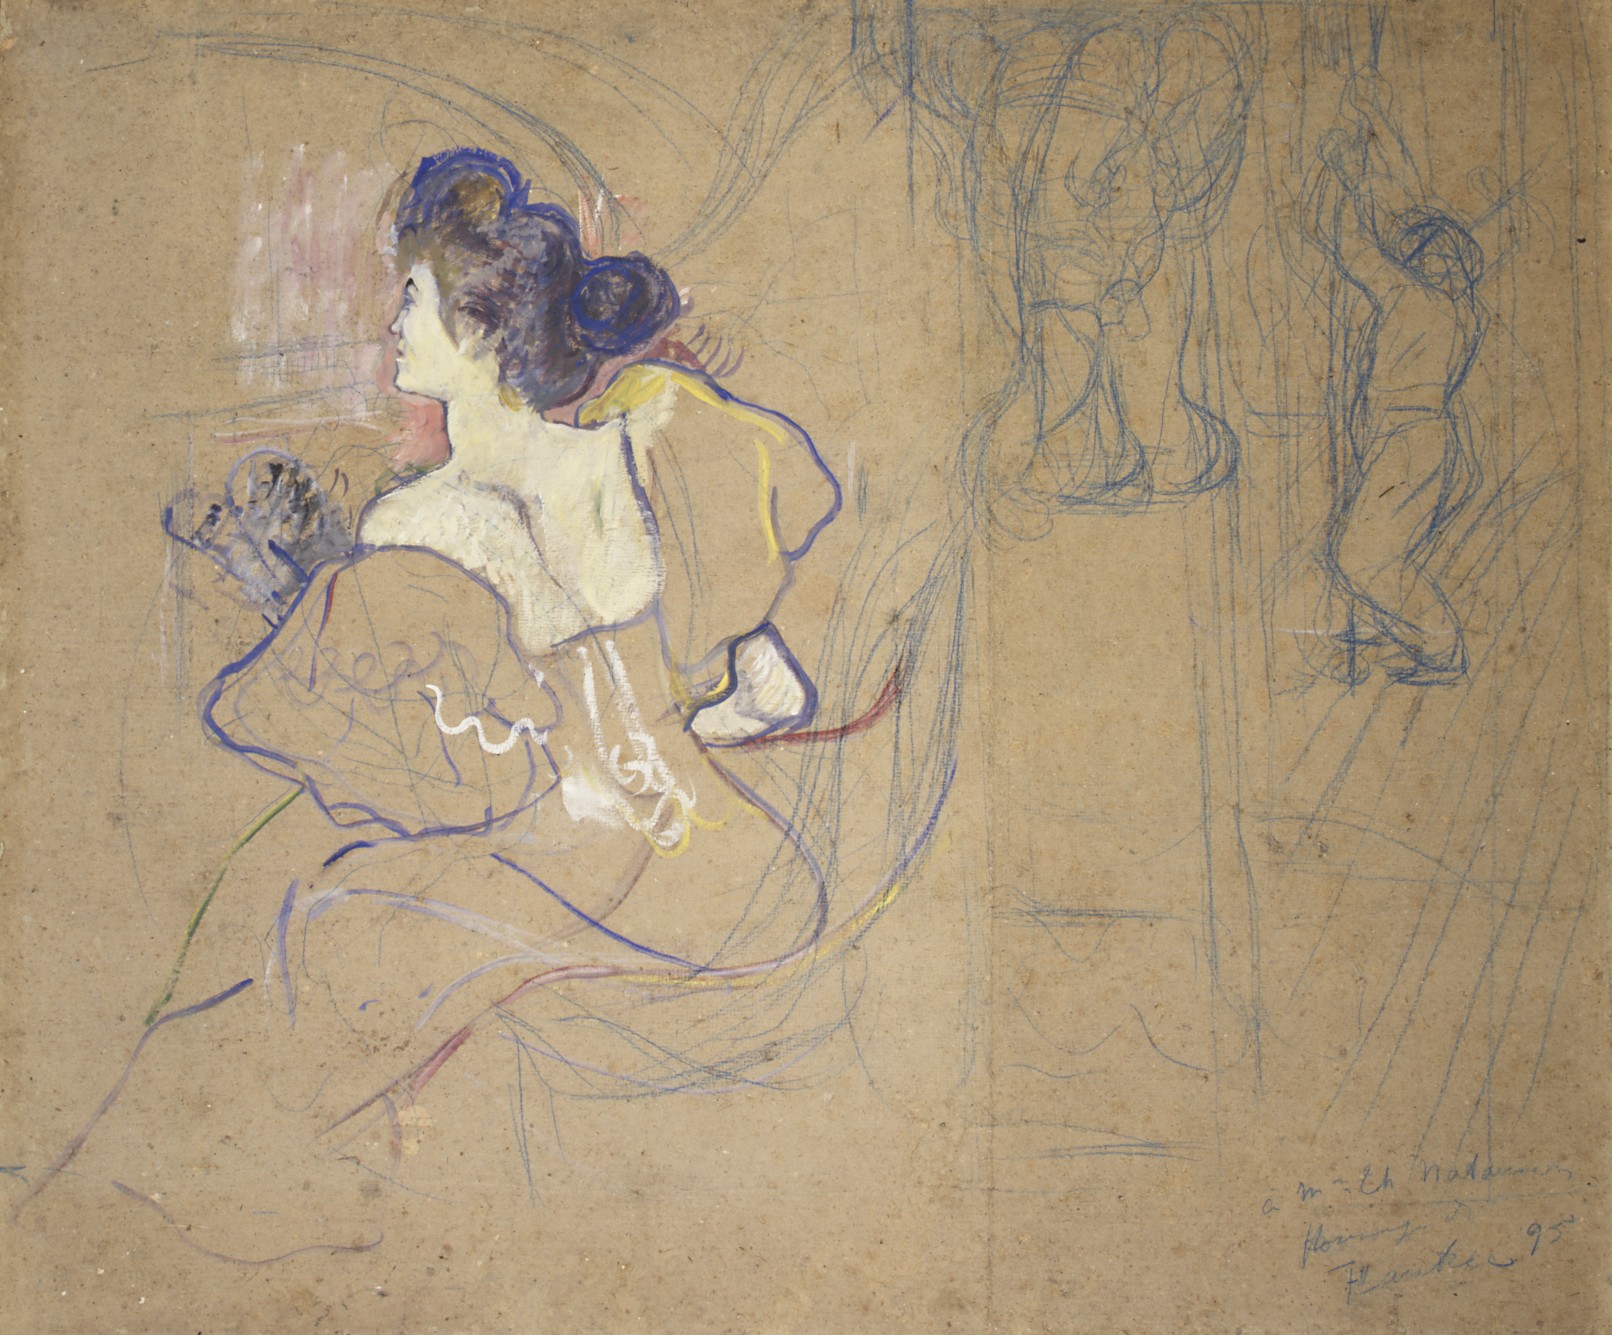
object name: drawing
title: Madame Thadée Natanson (Misia Godebska, 1872–1950) at the Theater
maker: henri de toulouse-lautrec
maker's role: artist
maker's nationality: french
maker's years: 1864-1901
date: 1895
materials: cardboard, oil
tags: women